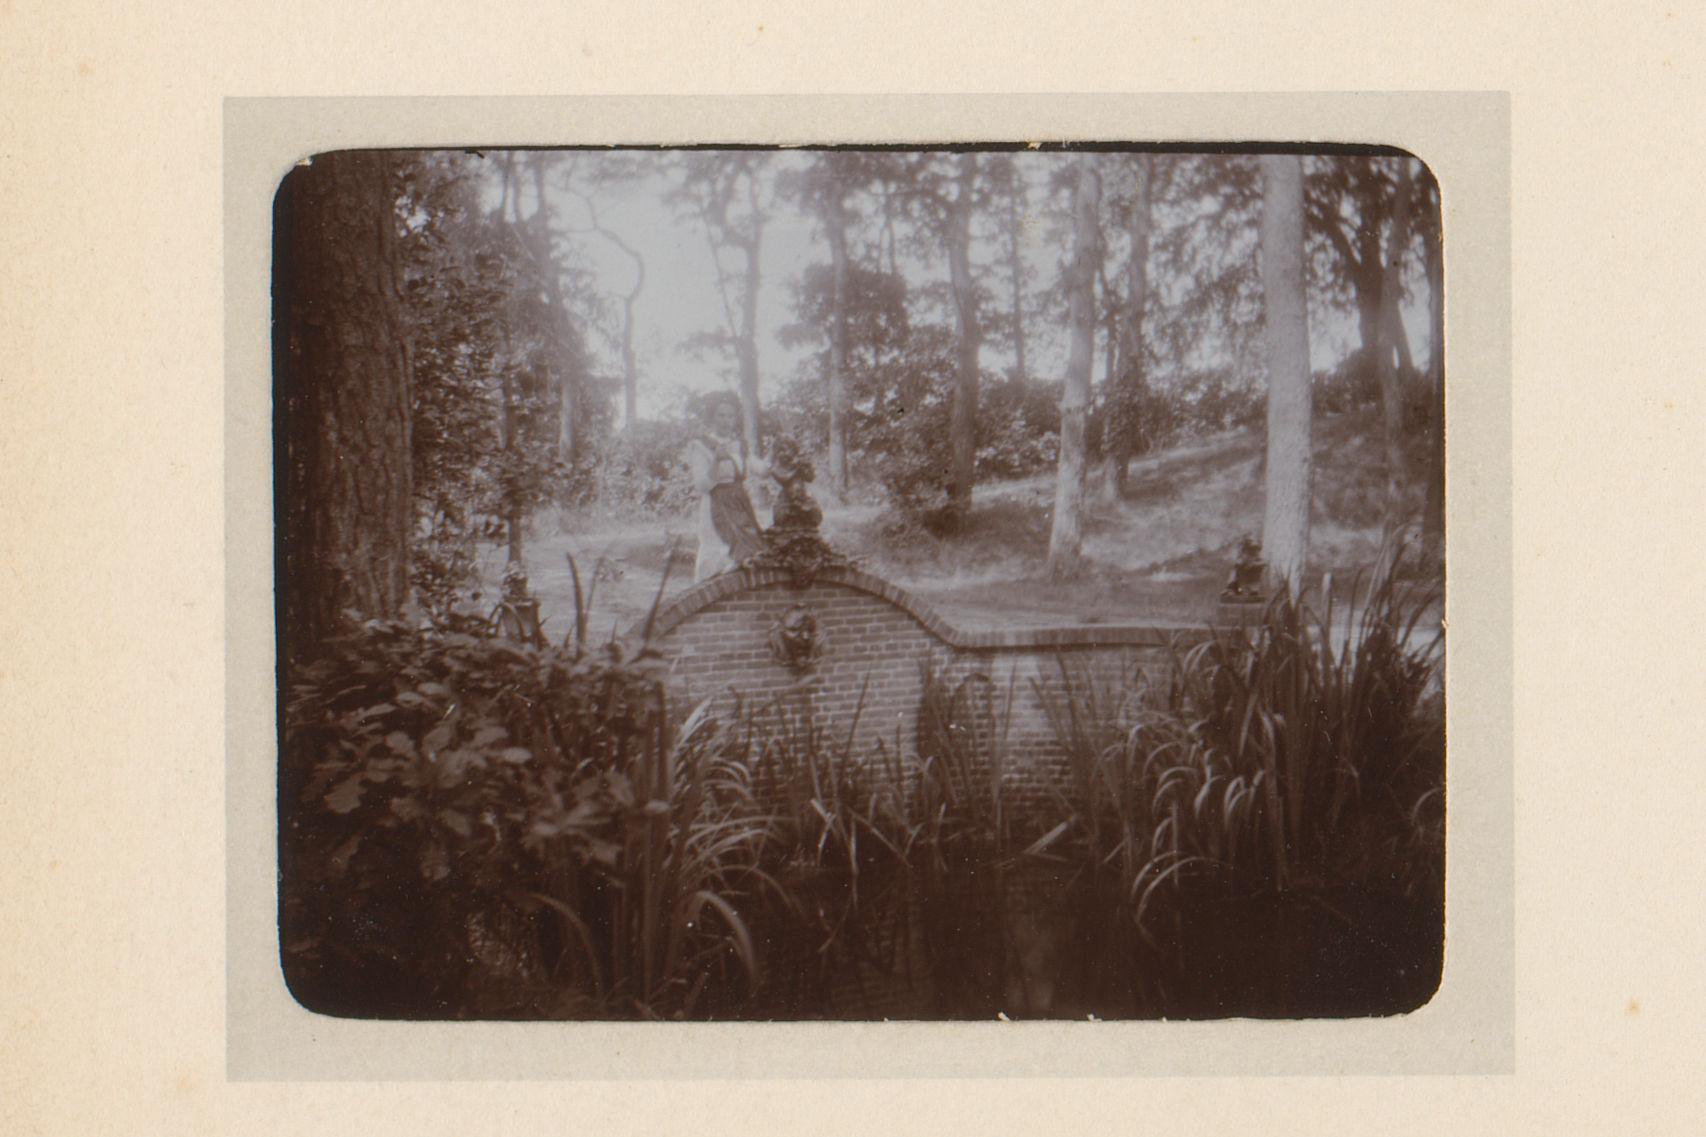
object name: photograph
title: Vrouw staande bij een waterpartij in een tuin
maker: liesbeth overhoff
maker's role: fotograaf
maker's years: 1895-1969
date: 1911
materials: paper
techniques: collodion silver print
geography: baarn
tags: adult woman, water-works in garden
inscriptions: inscription: ‘Baarn 1911’